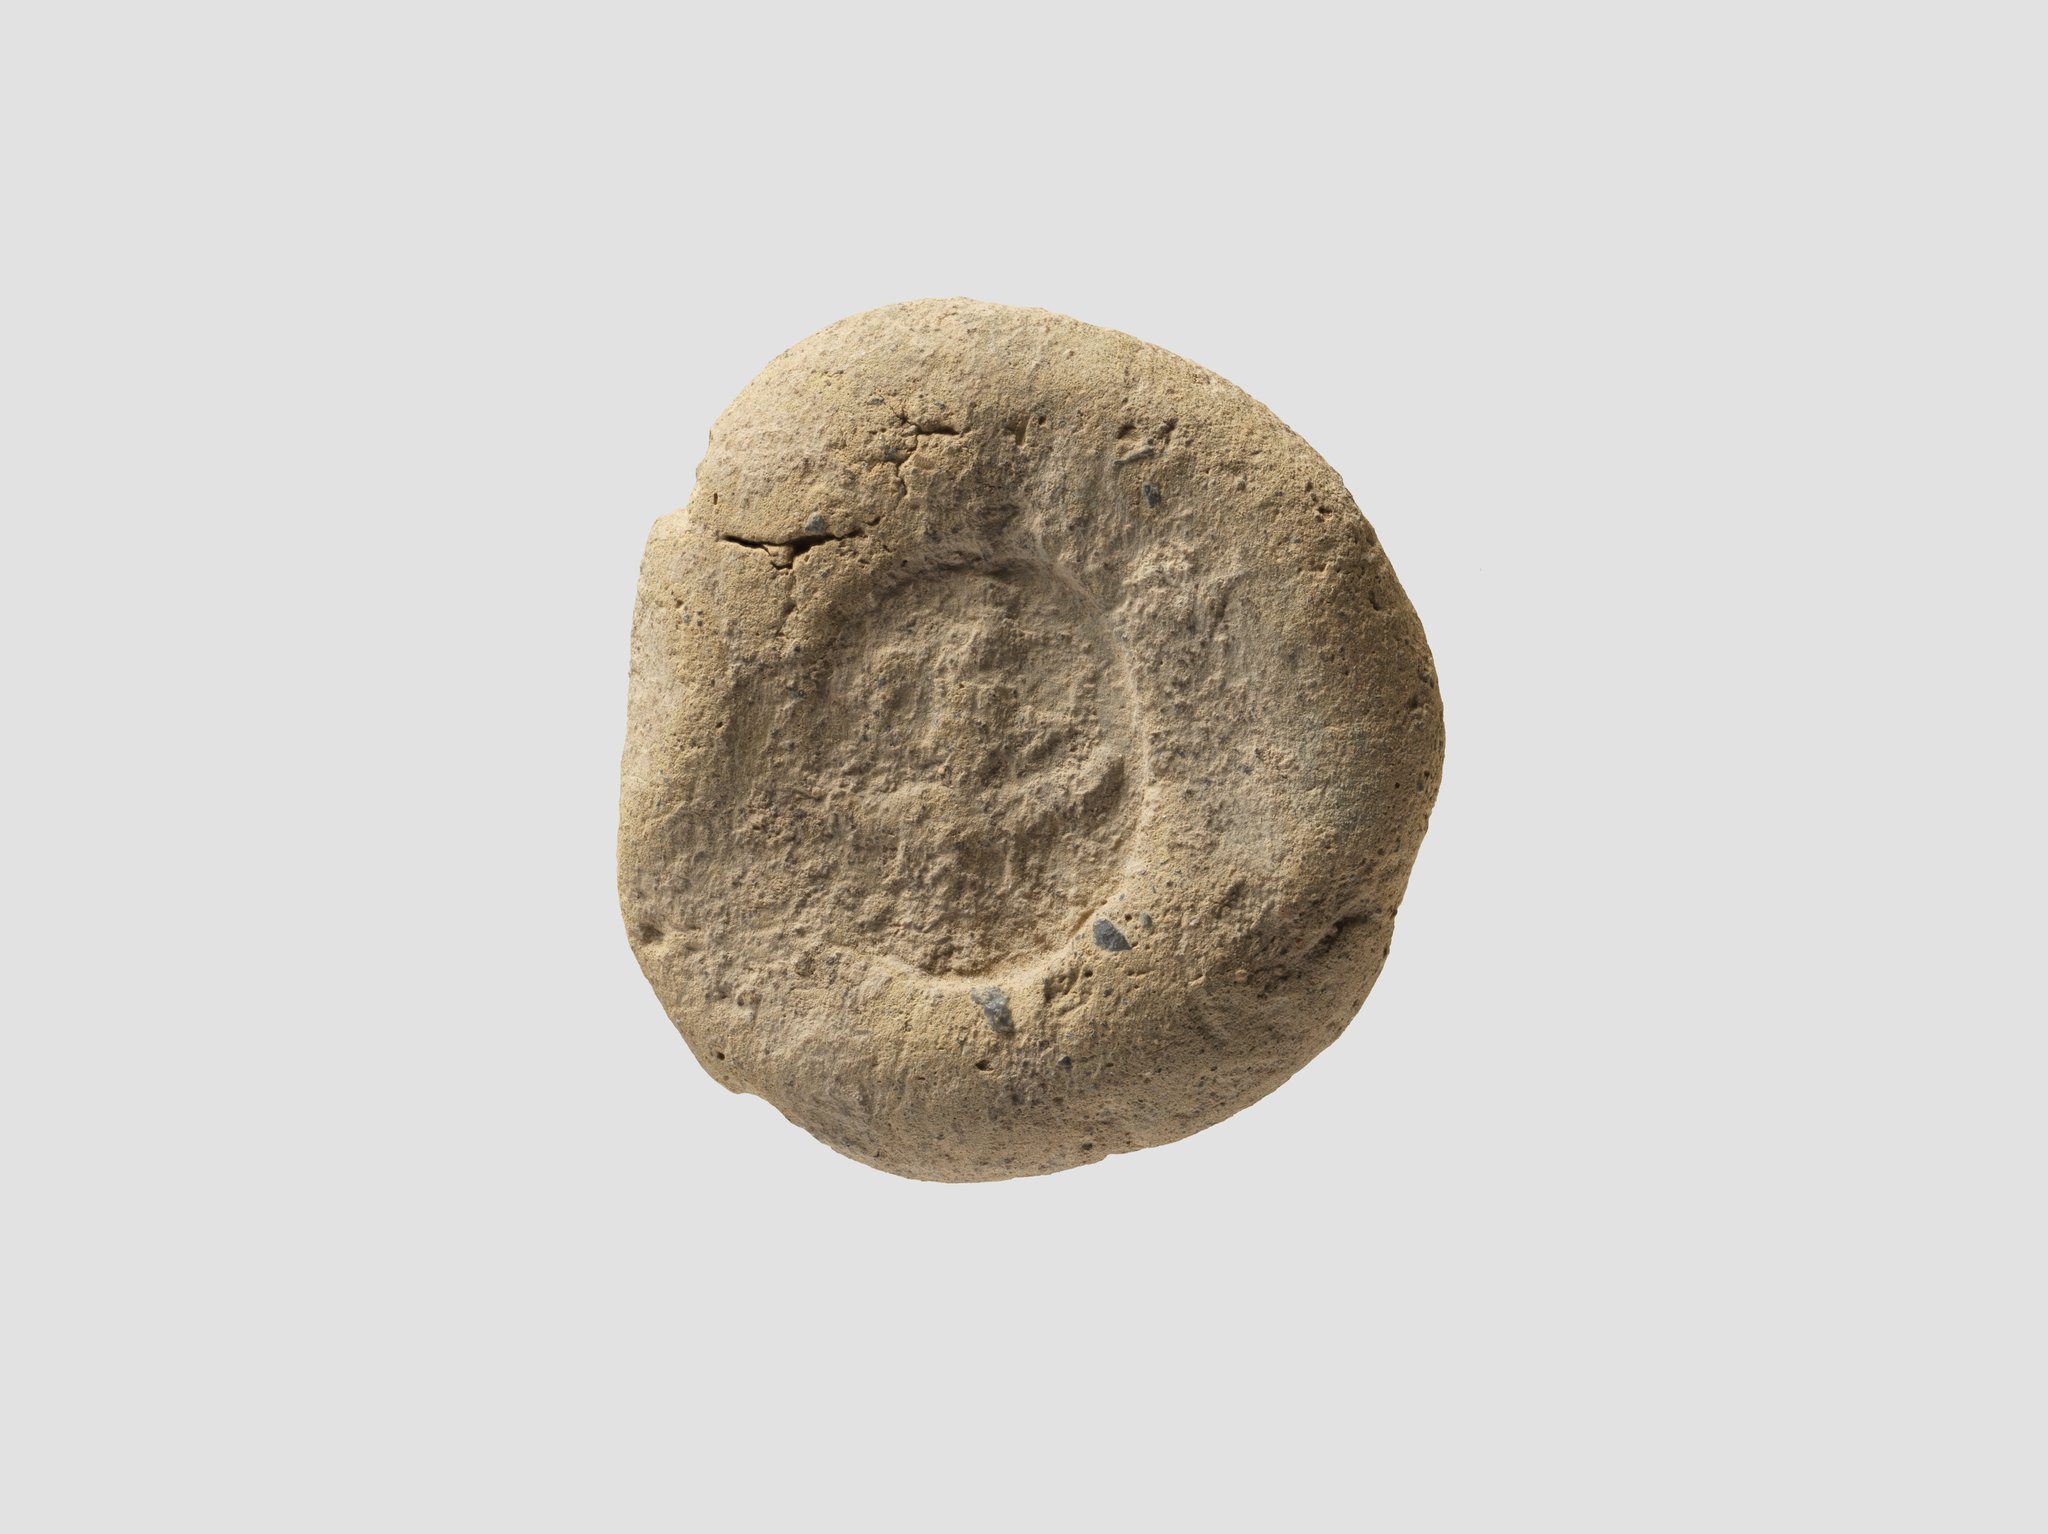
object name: bulla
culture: achaemenid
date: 567-301 BCE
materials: clay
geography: iran